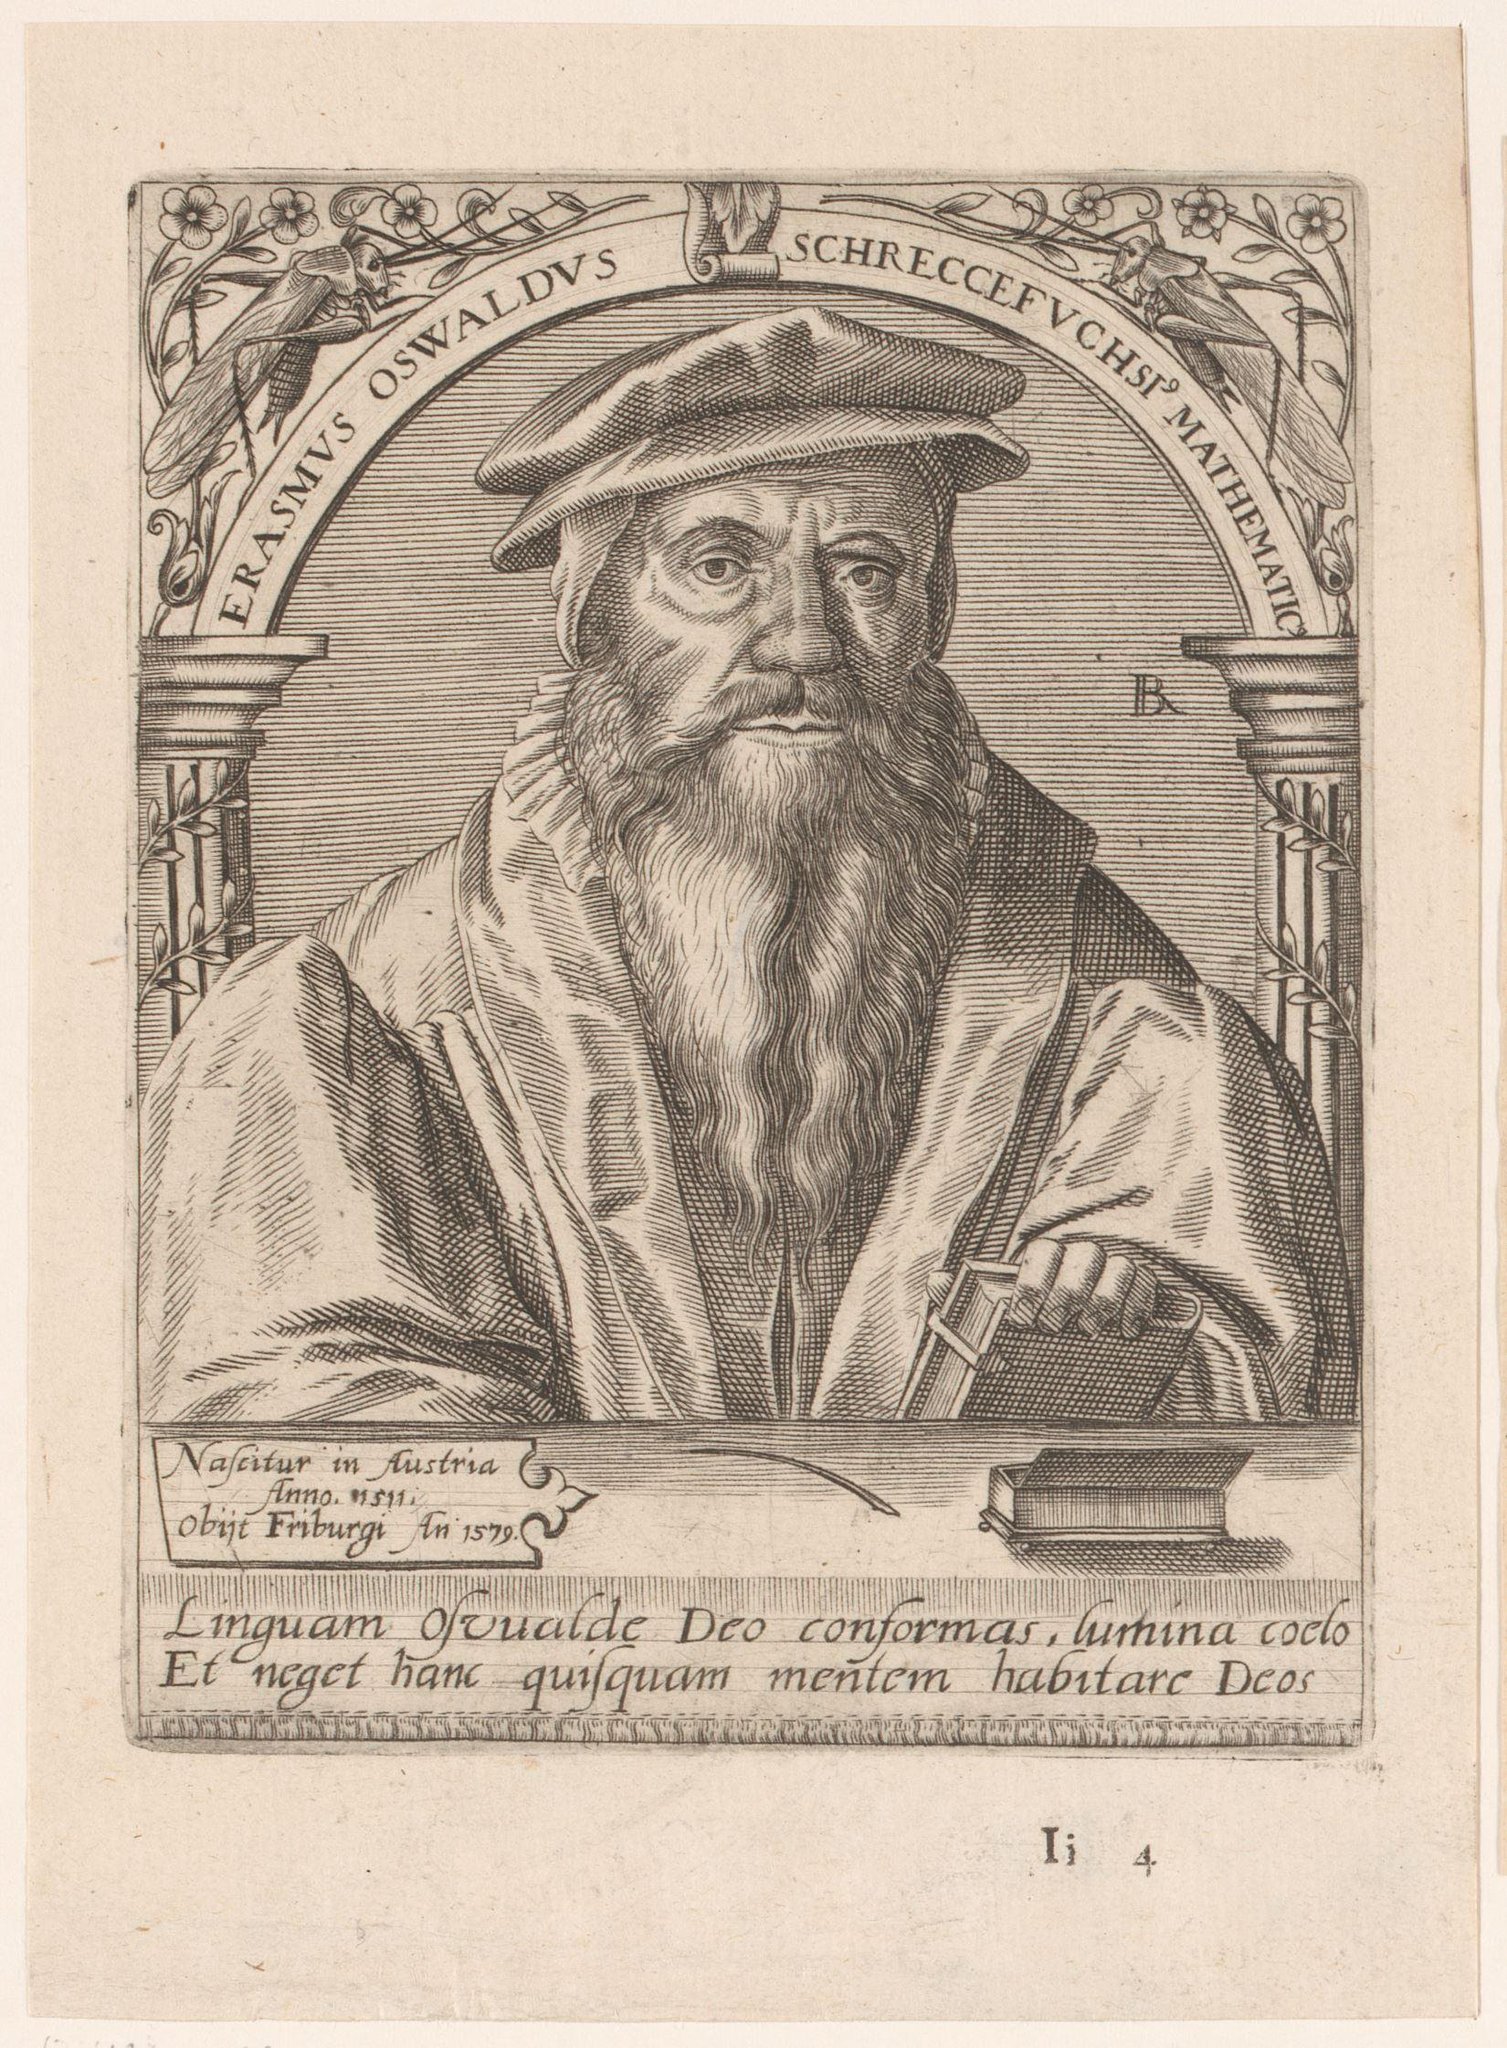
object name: book illustration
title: Erasmus Oswaldus Schreccefuchsi' mathematic'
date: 1597-1599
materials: paper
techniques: engraving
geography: france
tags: insects: grass-hopper - ff - fabulous animals (sometimes wrongly called 'grotesques'; 'mostri' (ripa), historical persons, book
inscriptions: collector's mark: Lugt 2228